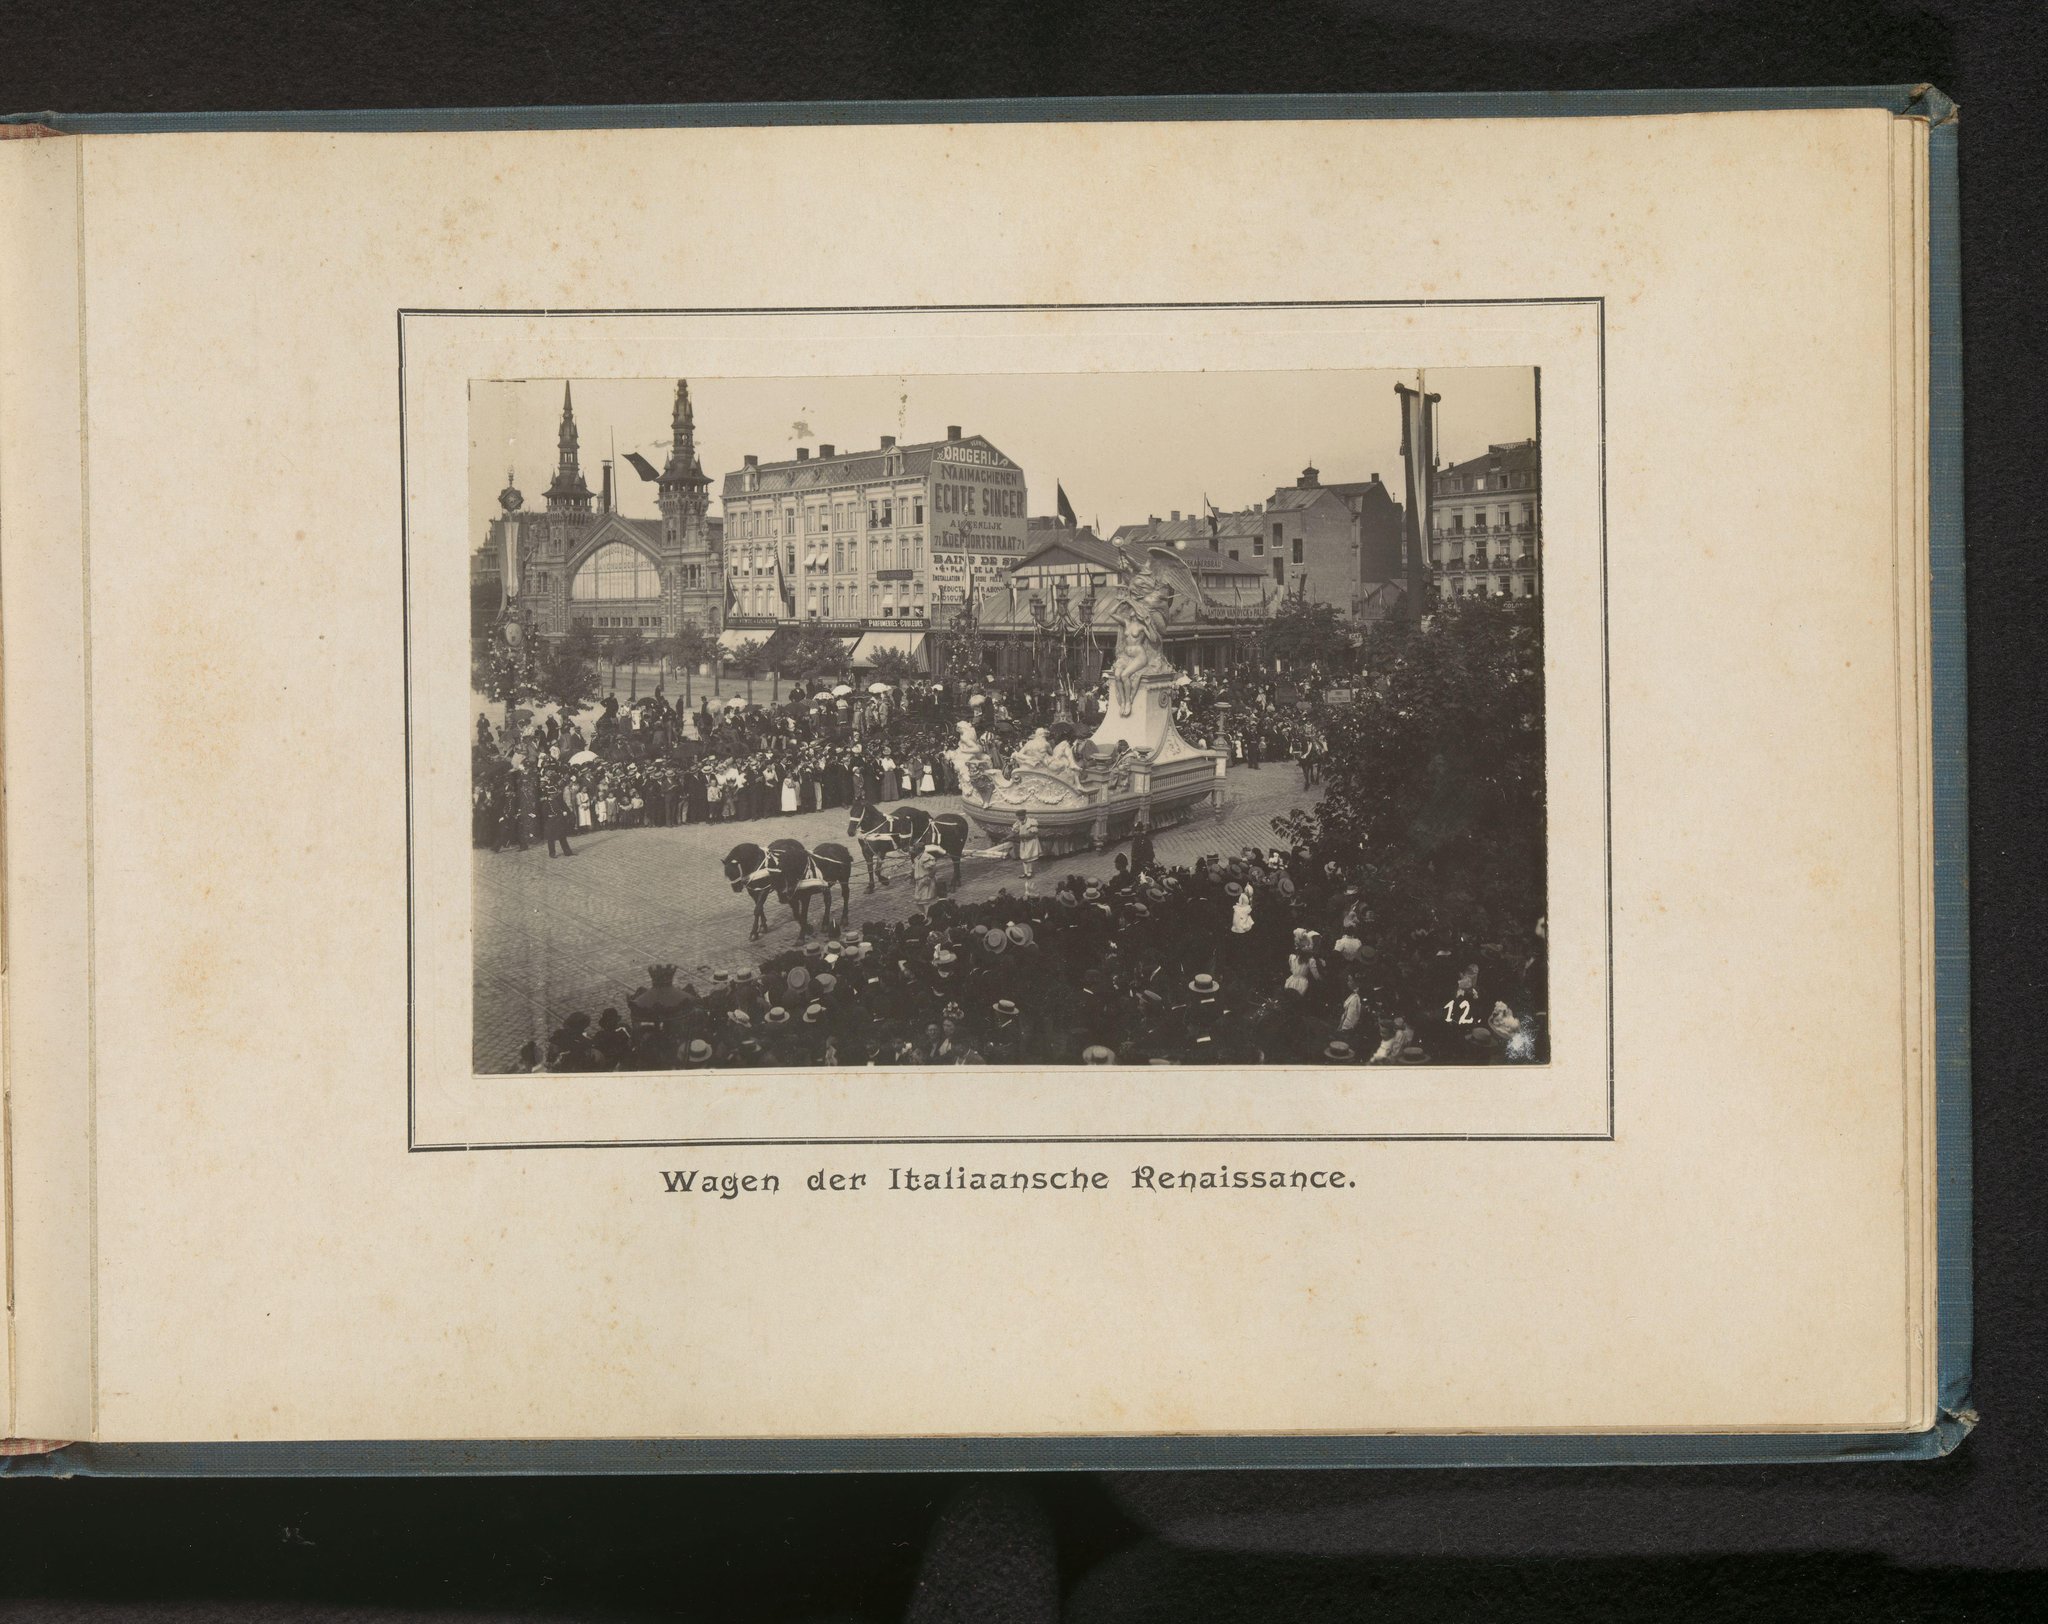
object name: photograph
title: Wagen der Italiaansche Renaissance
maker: Anonymous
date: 1899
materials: photographic support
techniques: printing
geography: antwerp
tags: animal traction, animal-drawn vehicle (carriage etc.), festivities (+ decorated float, wagon ~ festive activities), civic architecture; edifices; dwellings, antwerp